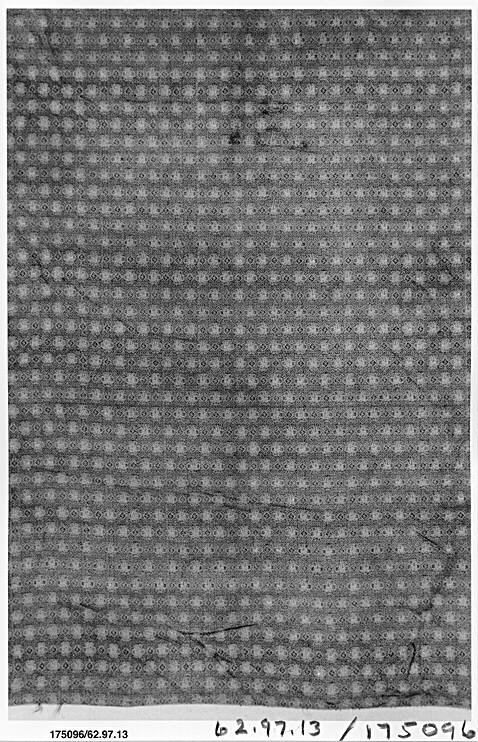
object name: piece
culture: chinese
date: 1701-1900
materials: silk